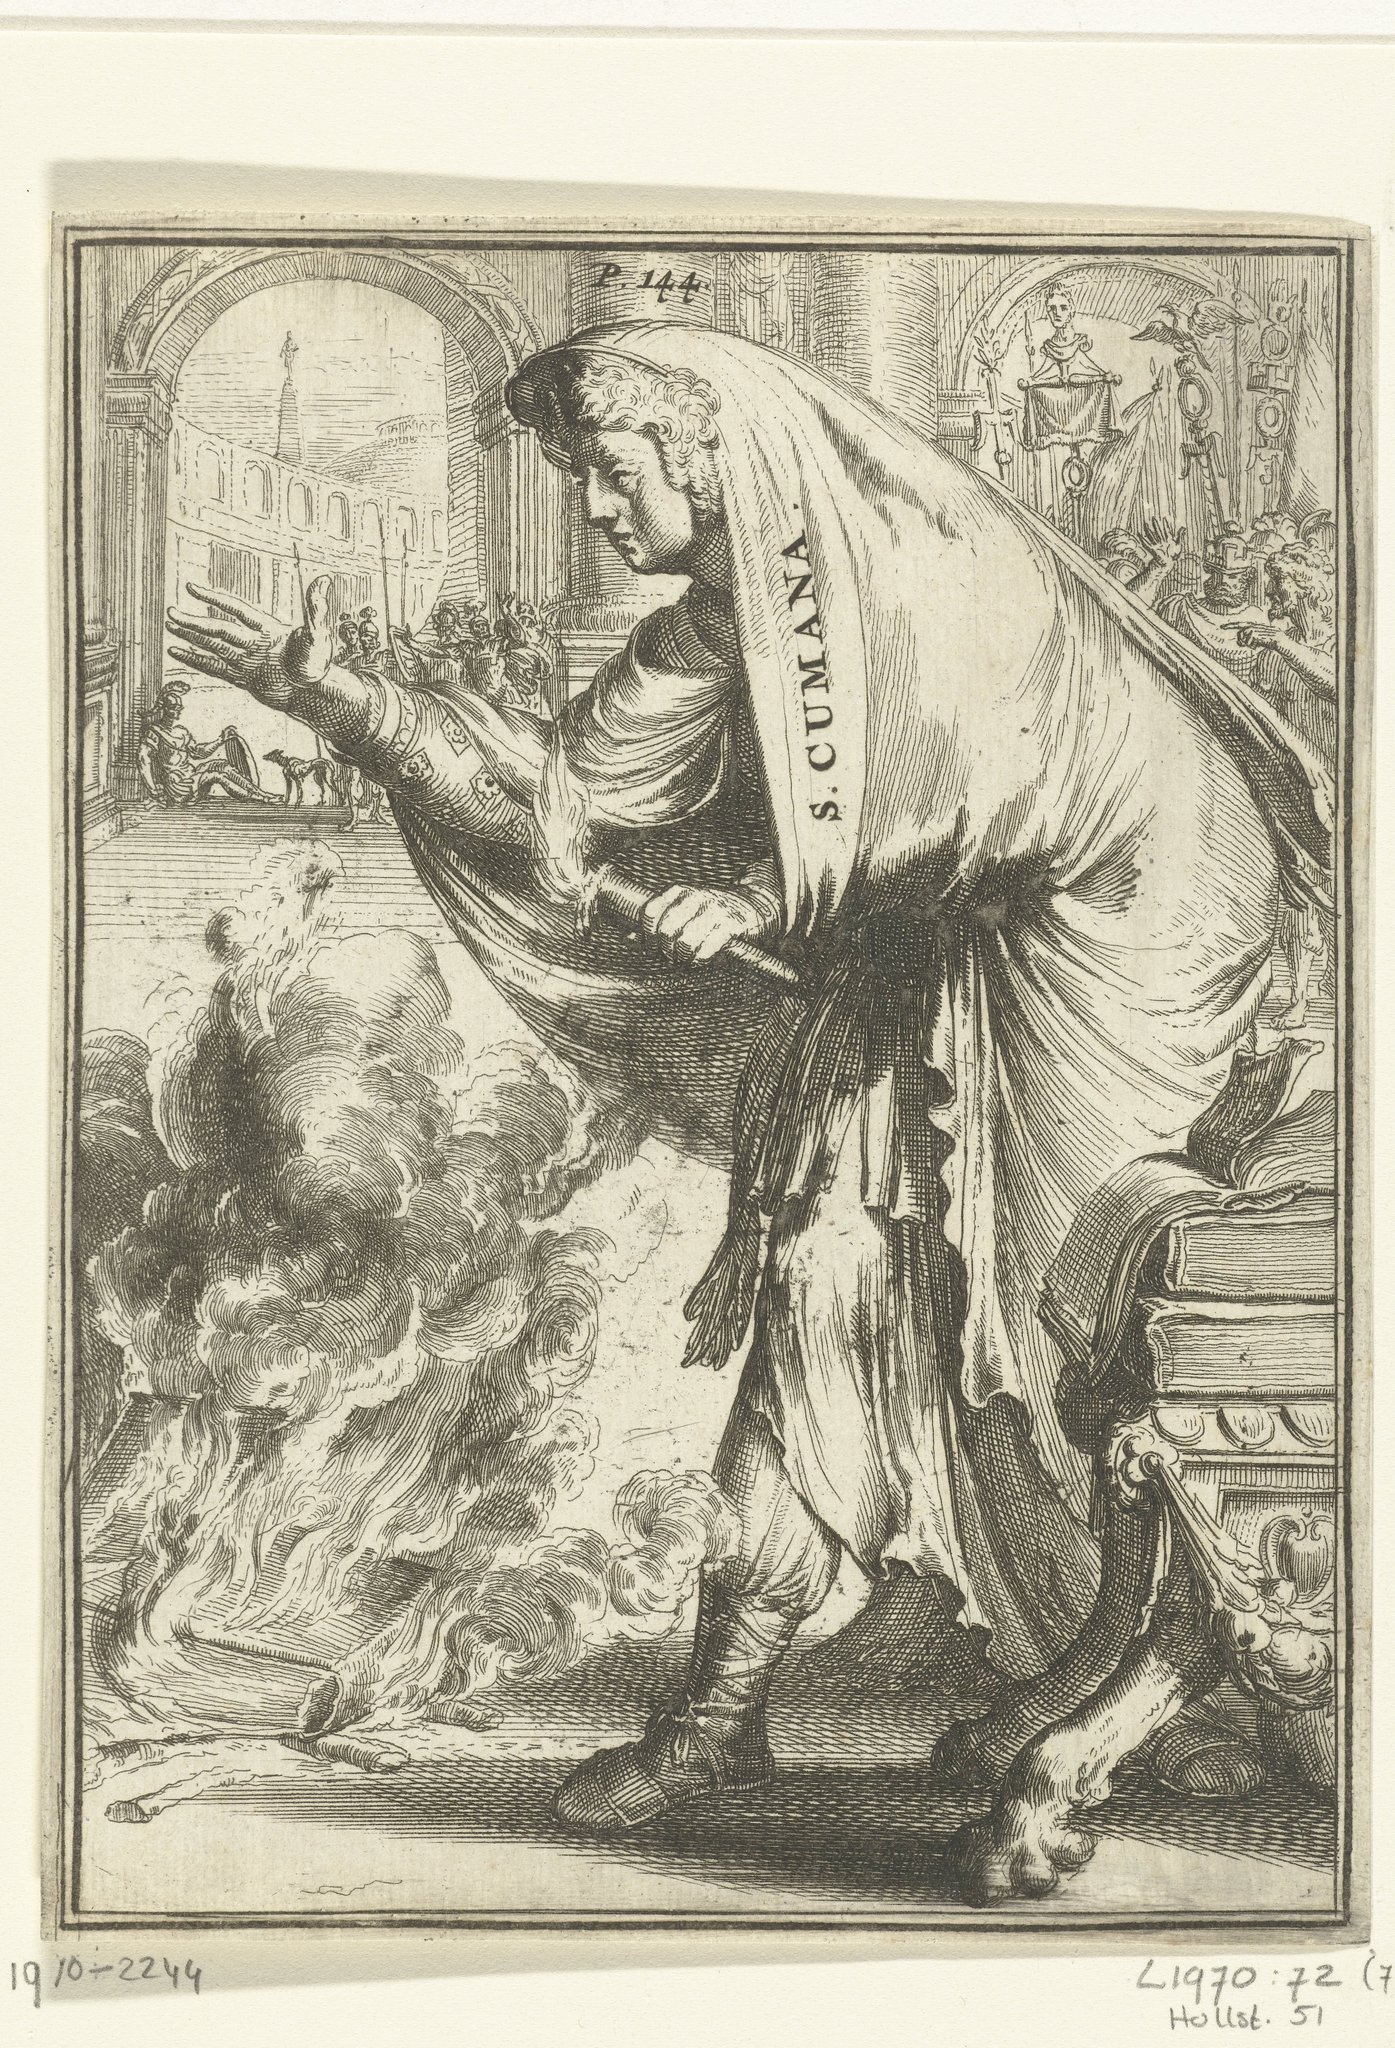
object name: book illustration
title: Twaalf sibillen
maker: romeyn de hooghe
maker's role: draughtsman, goldsmith, painter, print maker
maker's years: 1645-1708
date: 1688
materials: paper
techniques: engraving, etching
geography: netherlands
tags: cumaean sibyl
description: Illustratie voor: Servatius Gallaeus, Dissertationes de Sibyllis, earumque oraculis, Amsterdam, Dirk en Hendrik Boom, 1688, p. 144.